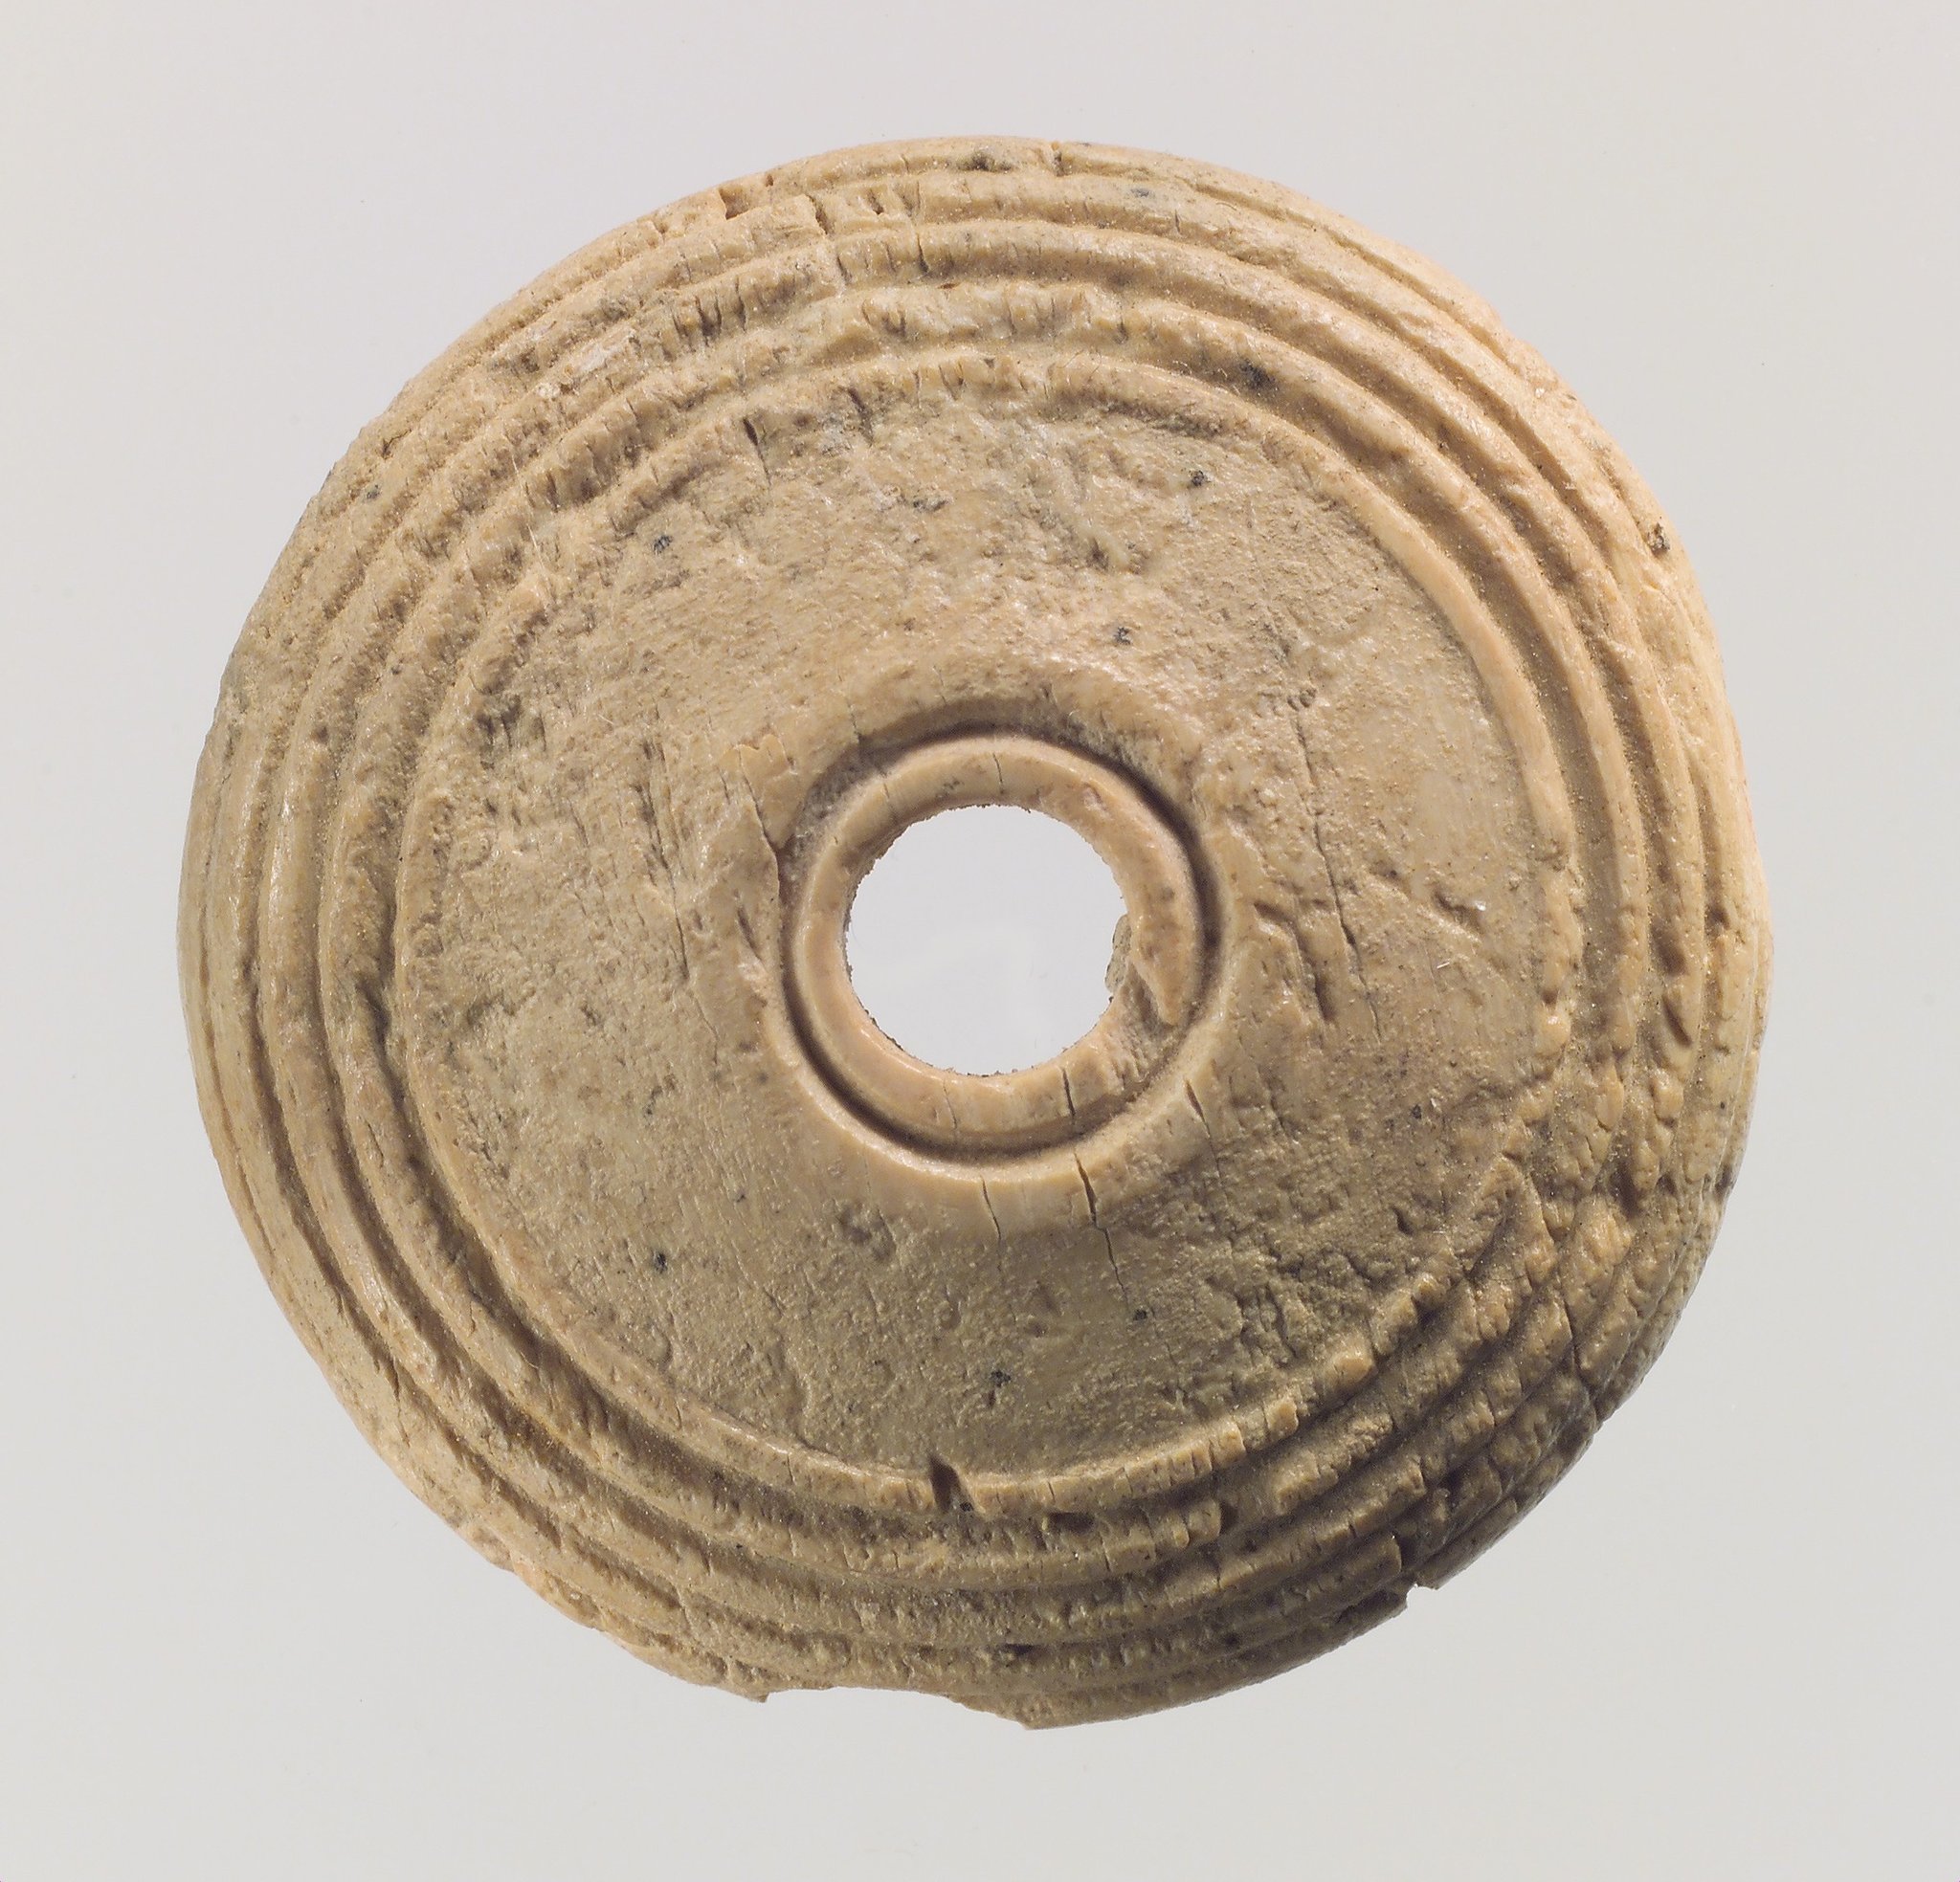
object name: button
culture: sasanian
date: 201-700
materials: bone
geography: iran